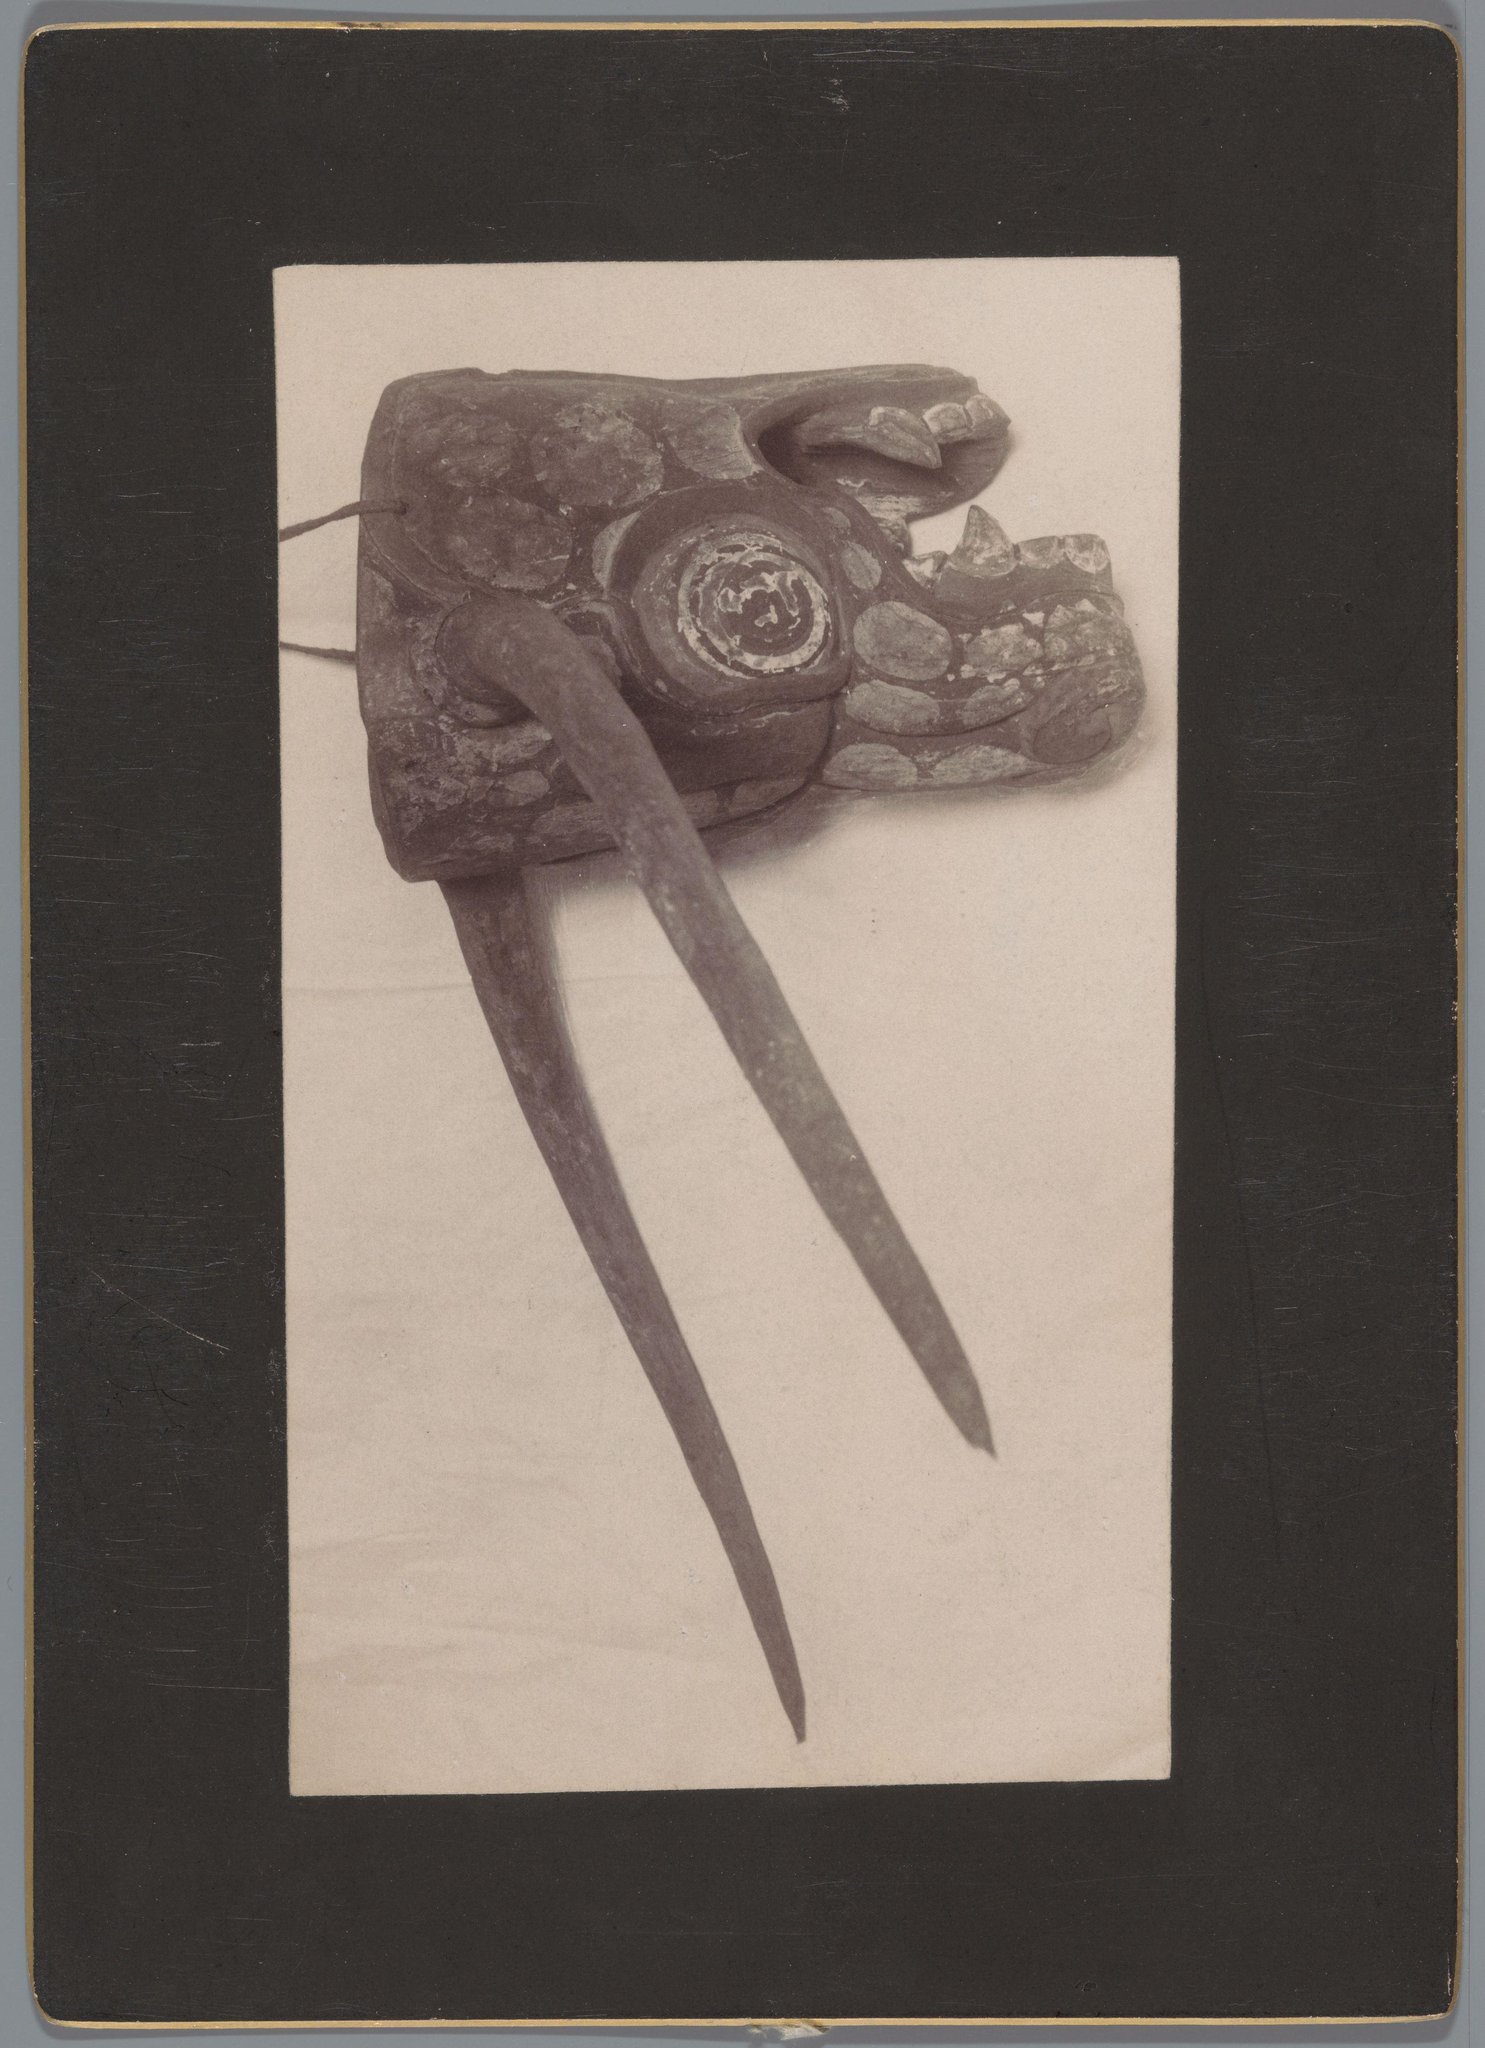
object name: photograph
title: Tibetaans masker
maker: Anonymous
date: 1897-1910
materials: cardboard, paper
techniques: albumen print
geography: rijks ethnographisch museum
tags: mask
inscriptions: inscription: ‘Masker voor den duivelsdans/ De stierhoofdige demon/ (De heilige Koning van de Be[...])/ Lg ±3 n; afstand der hooren 95 elk/ Thibet’